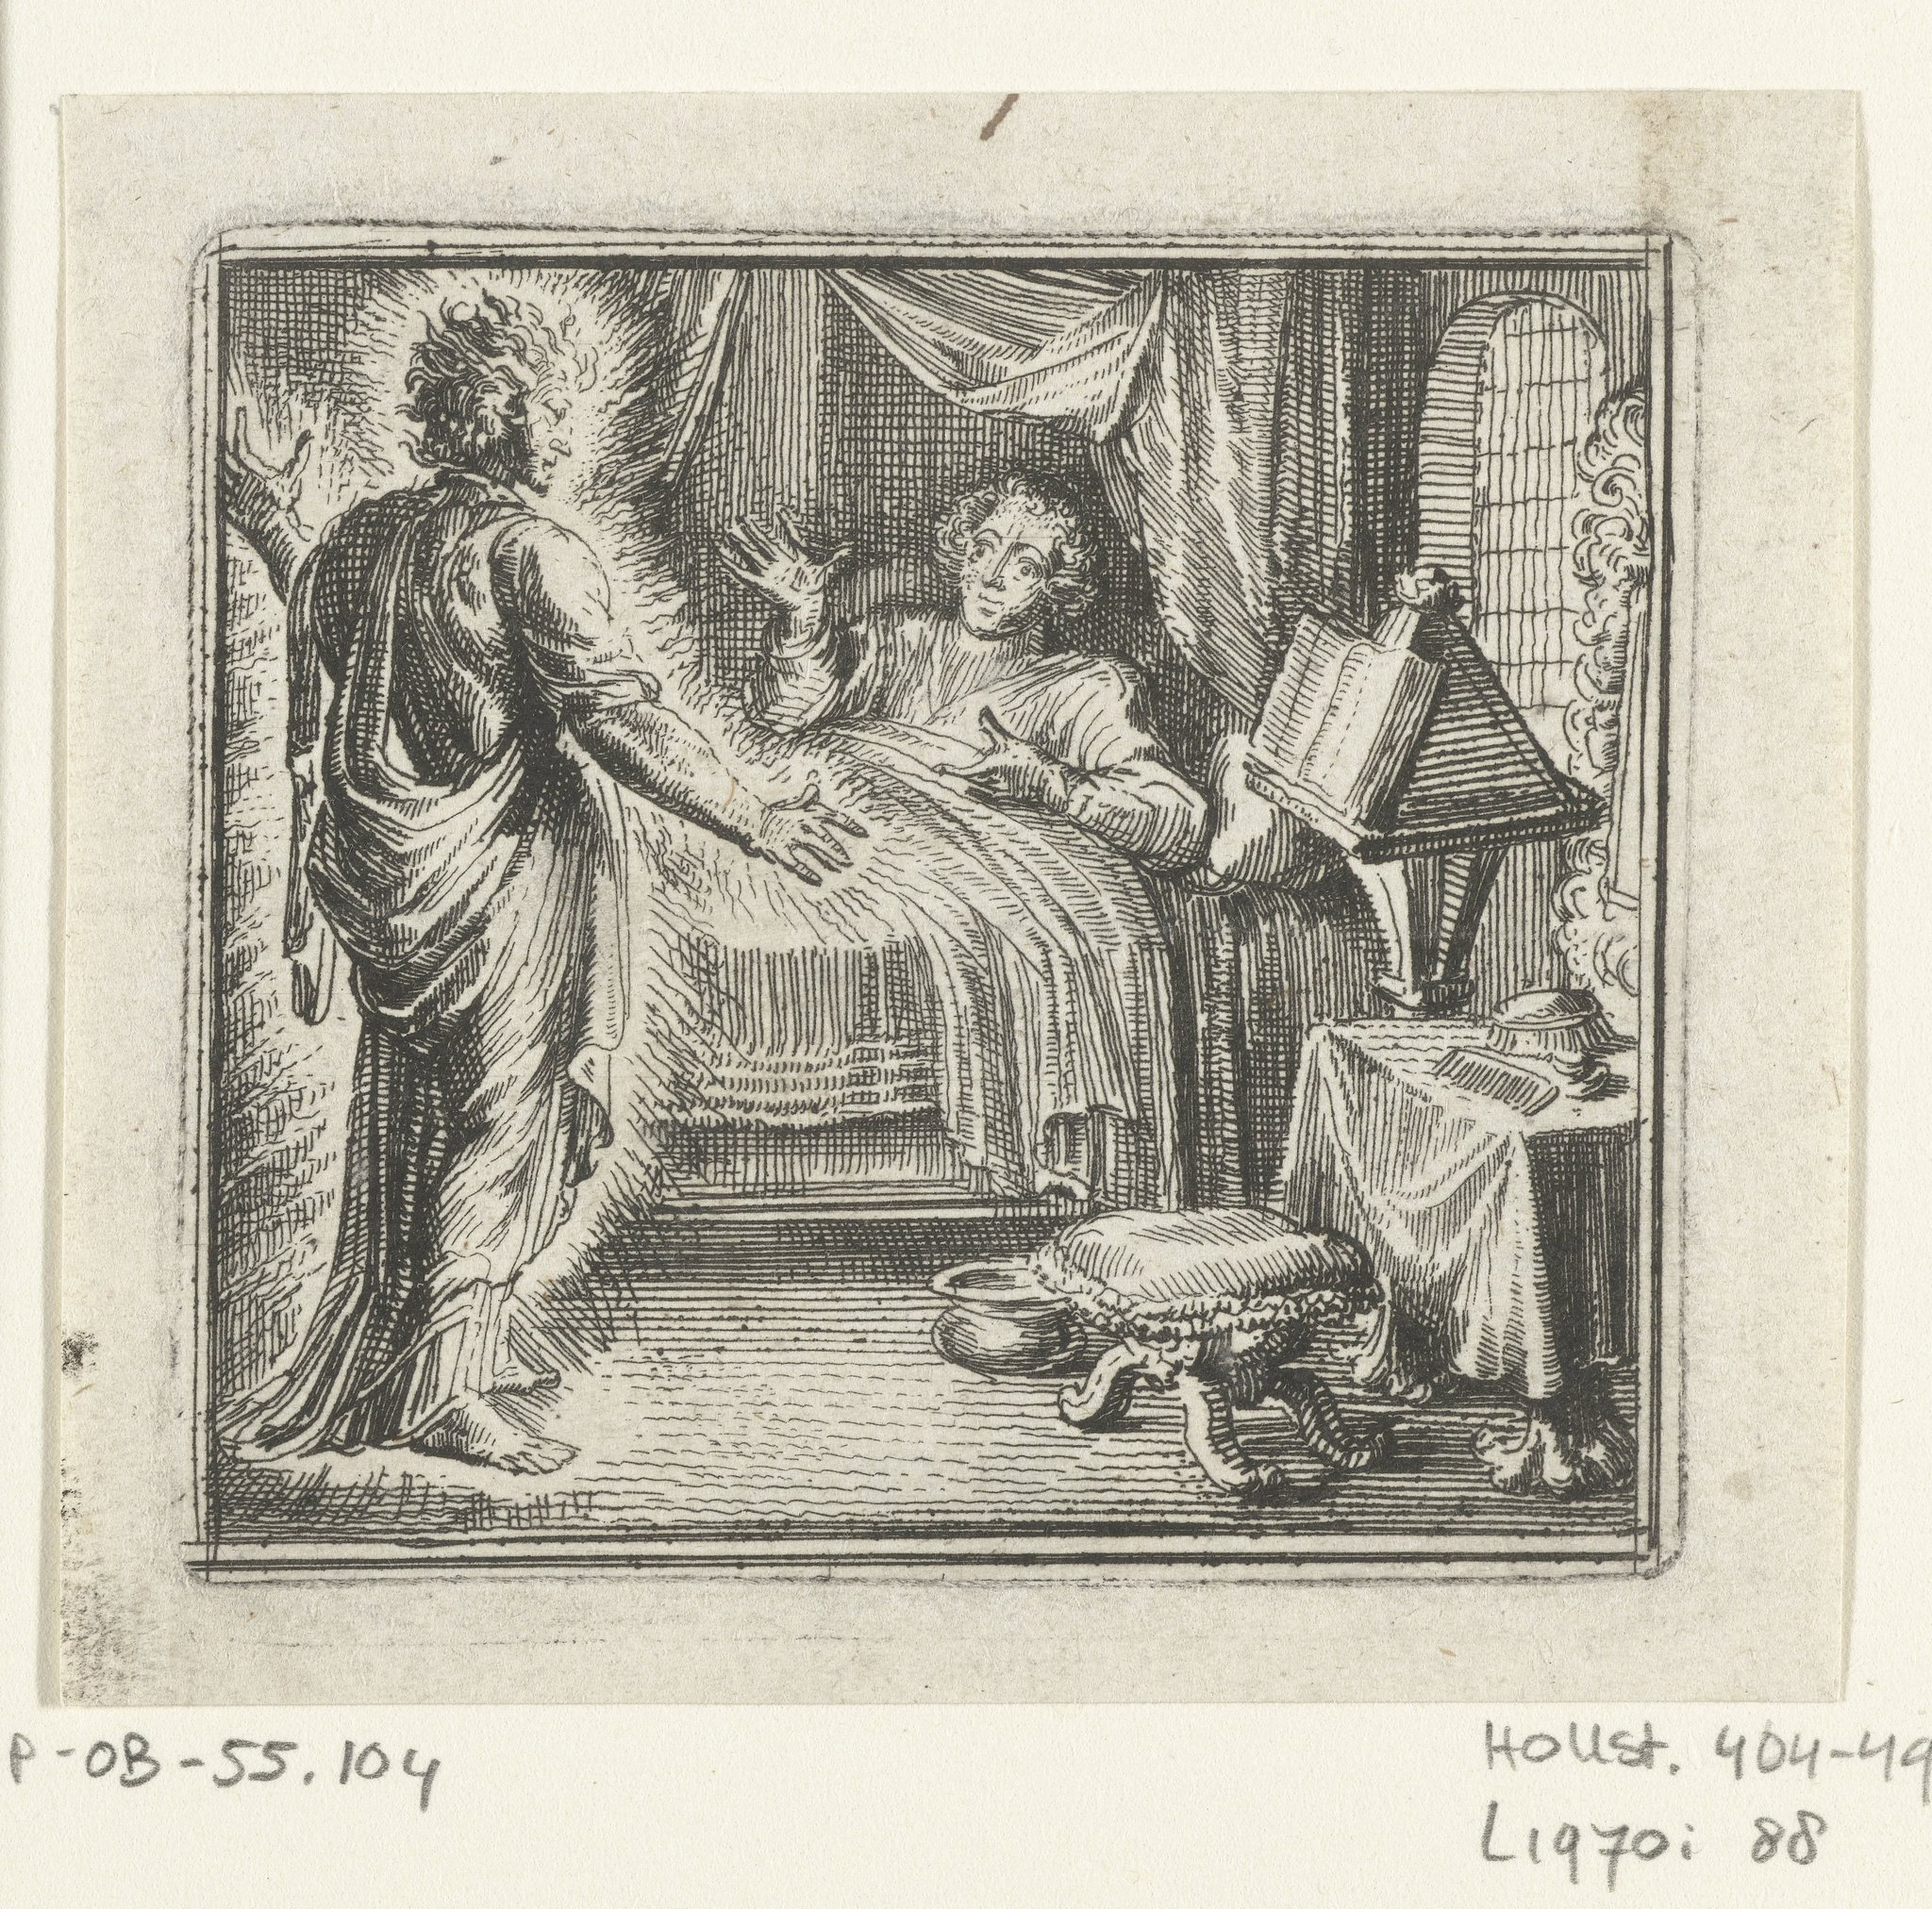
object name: book illustration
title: Illustratie voor de Decamerone van Boccaccio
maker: romeyn de hooghe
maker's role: draughtsman, goldsmith, painter, print maker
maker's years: 1645-1708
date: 1697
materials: paper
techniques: etching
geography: netherlands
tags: (scenes from) specific works of literature: boccaccio, decamerone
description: Illustratie voor: Contes et nouvelles de Bocace Florentin. Traduction libre, 2 delen, Amsterdam, George Gallet, 1697. Latere edities met dezelfde illustraties uit 1699, 1702, 1732.